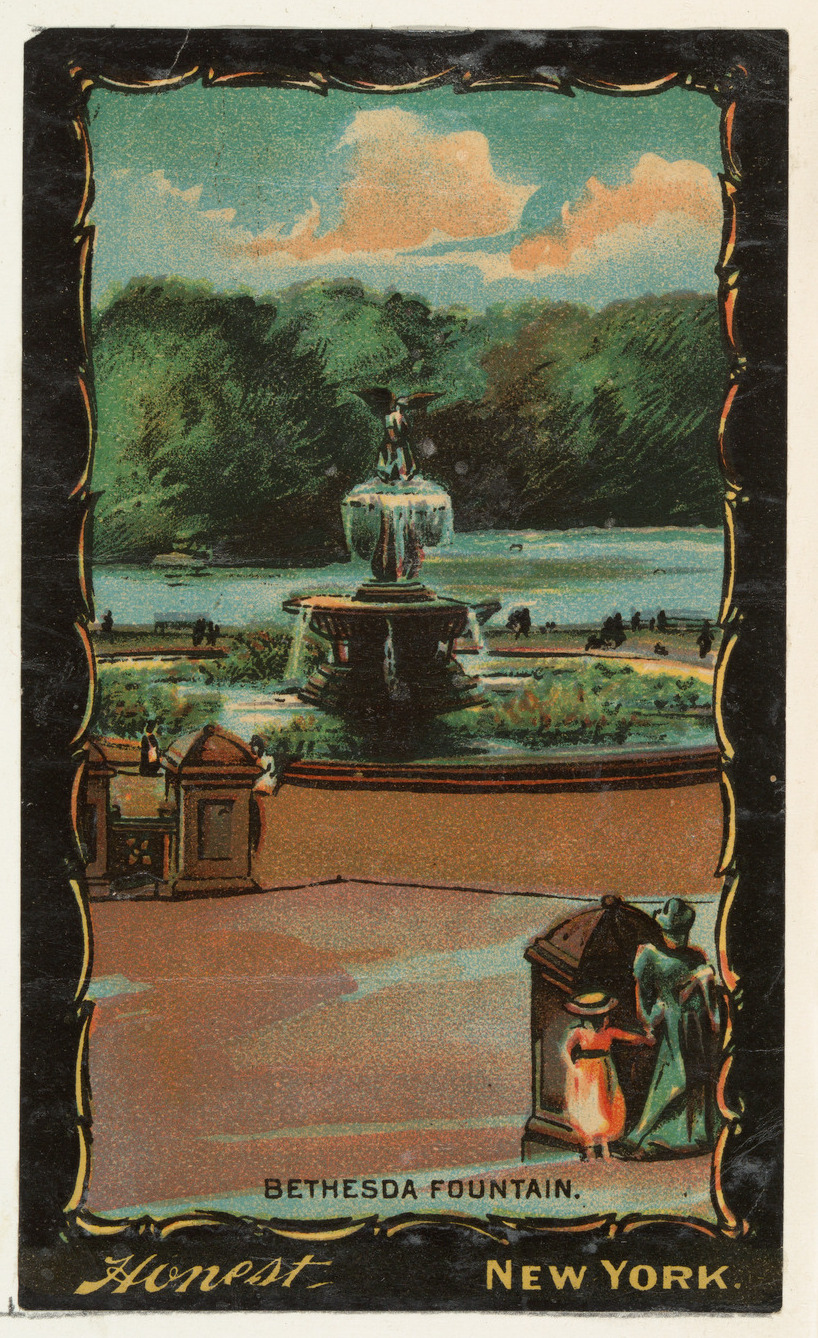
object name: print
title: Bethesda Fountain, Central Park, New York City, from the Transparencies series (N137) issued by W. Duke, Sons & Co. to promote Honest Long Cut Tobacco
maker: w. duke, sons & co.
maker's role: publisher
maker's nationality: american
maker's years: 1870-1920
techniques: color lithograph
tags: fountains,parks,new york city